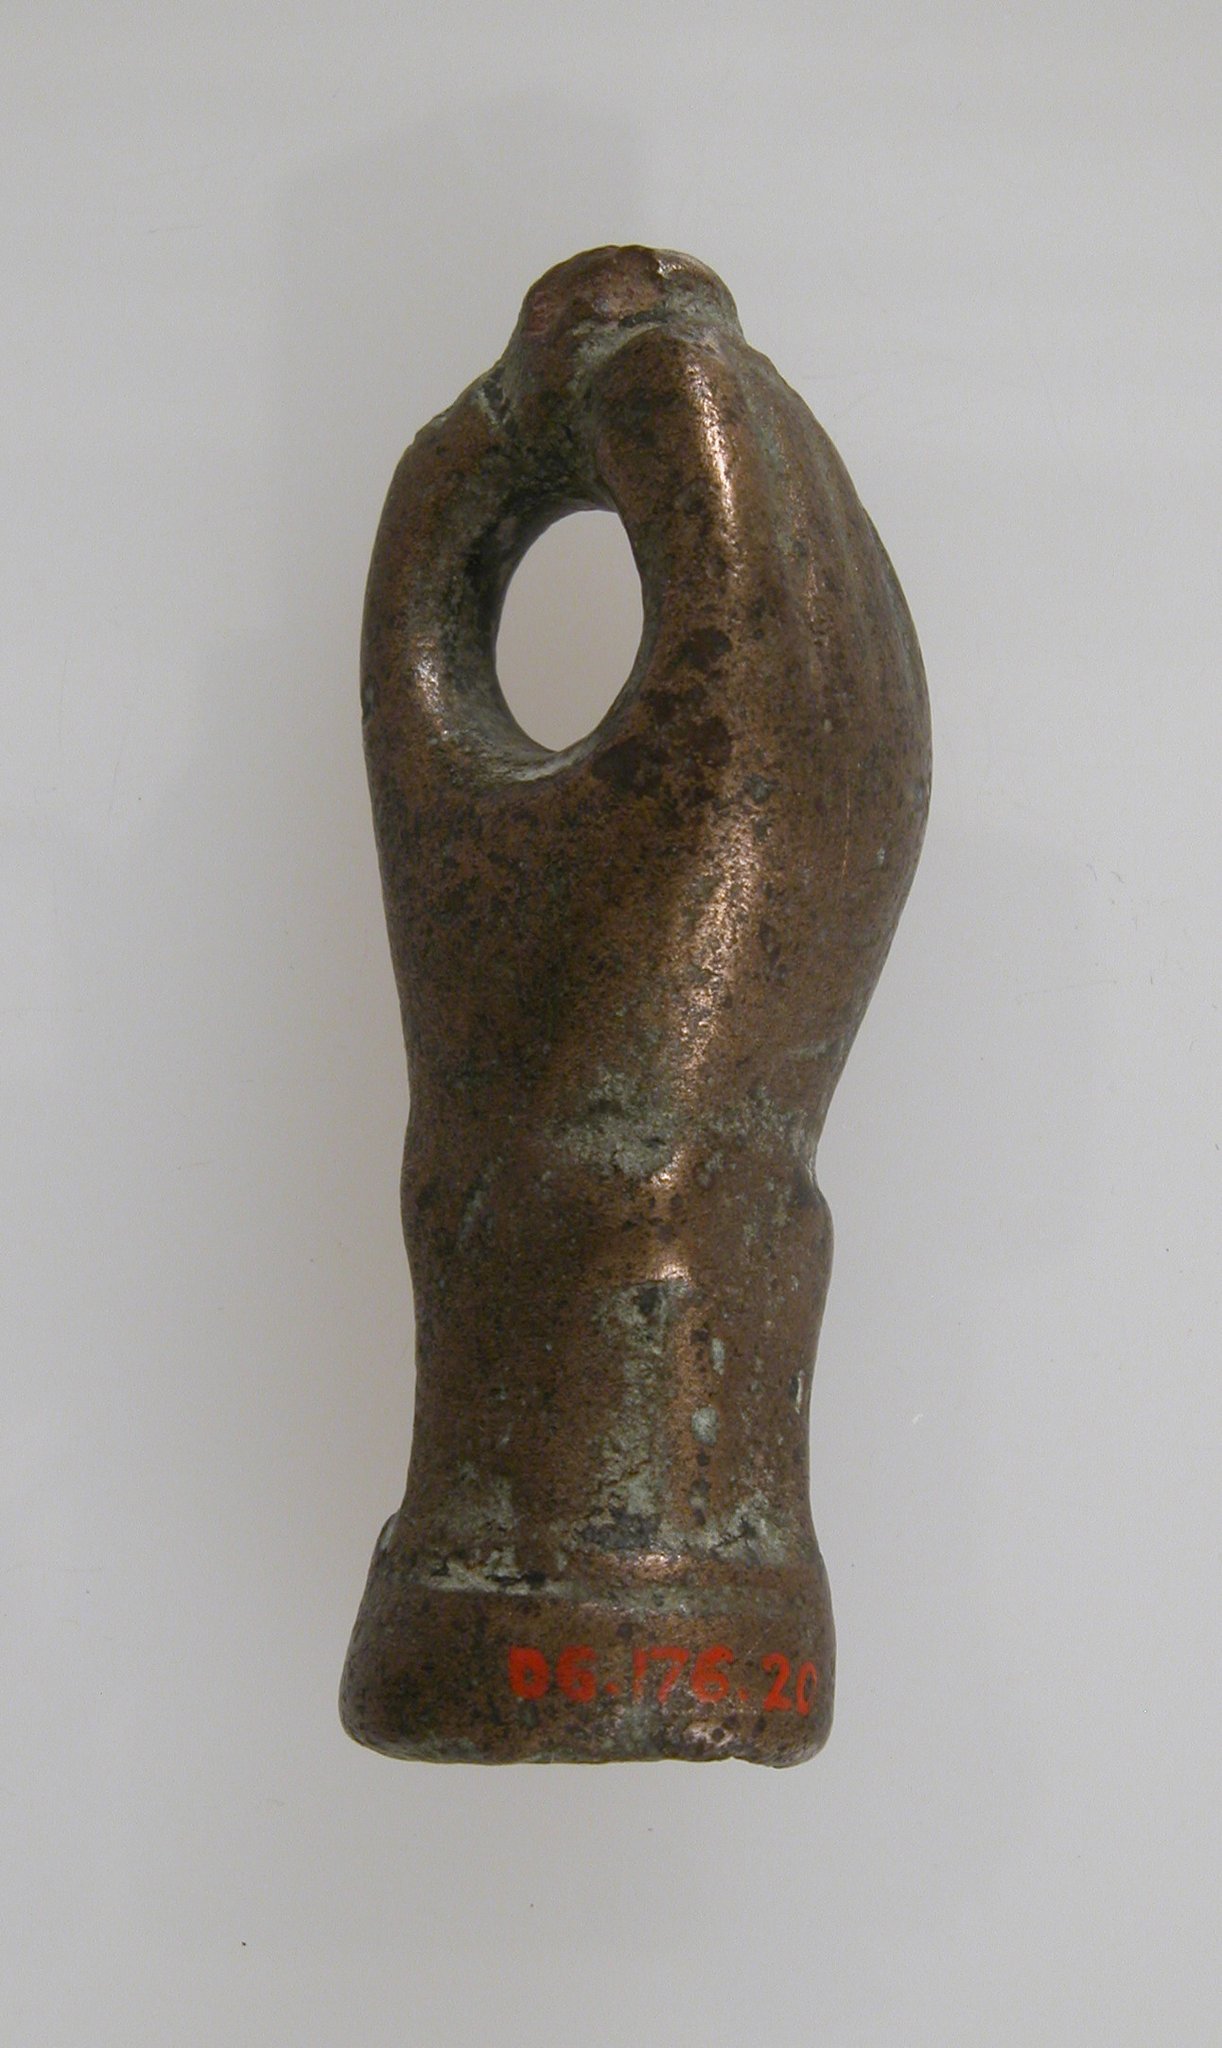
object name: key handle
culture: roman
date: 1-700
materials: copper alloy